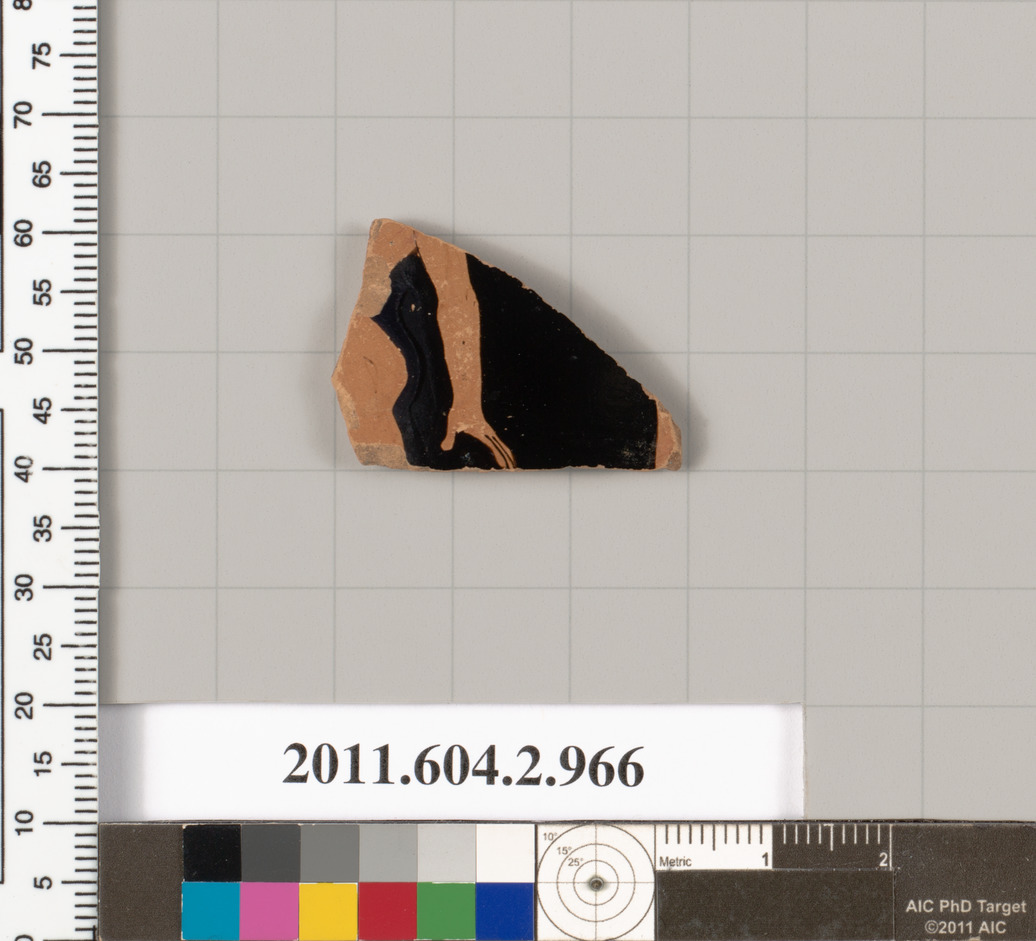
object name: oinochoe fragment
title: Terracotta fragment of an oinochoe (jug)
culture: greek, attic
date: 475-451 BCE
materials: terracotta